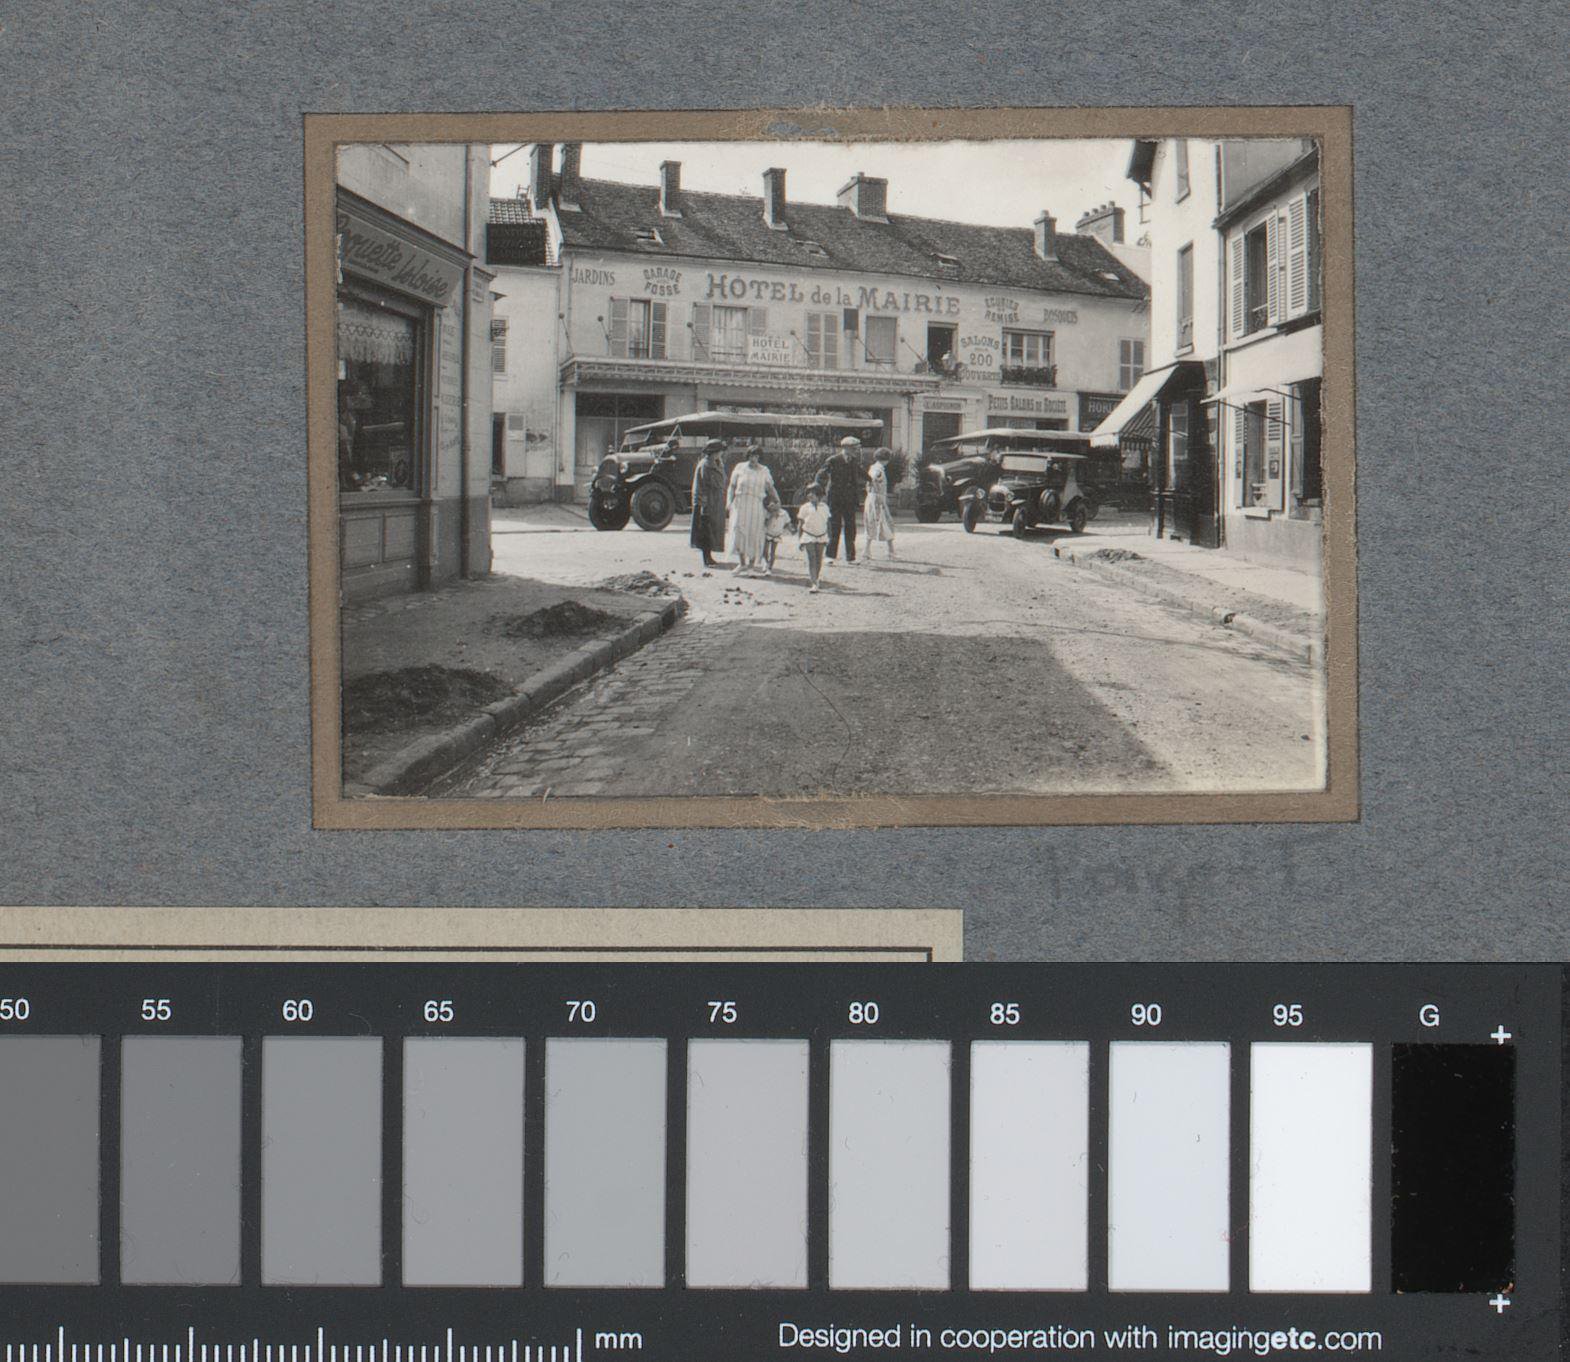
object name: album leaf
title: Straatgezicht in een Frans dorp met gezin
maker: Anonymous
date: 1910-1930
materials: photographic support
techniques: gelatin silver print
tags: family life, village street (+ city(-scape) with figures, staffage)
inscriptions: inscription: ‘Opnamen gemaakt met de Zak-Kodak"No.1./ Afdrukken gemaakt op "Velox" papier.’